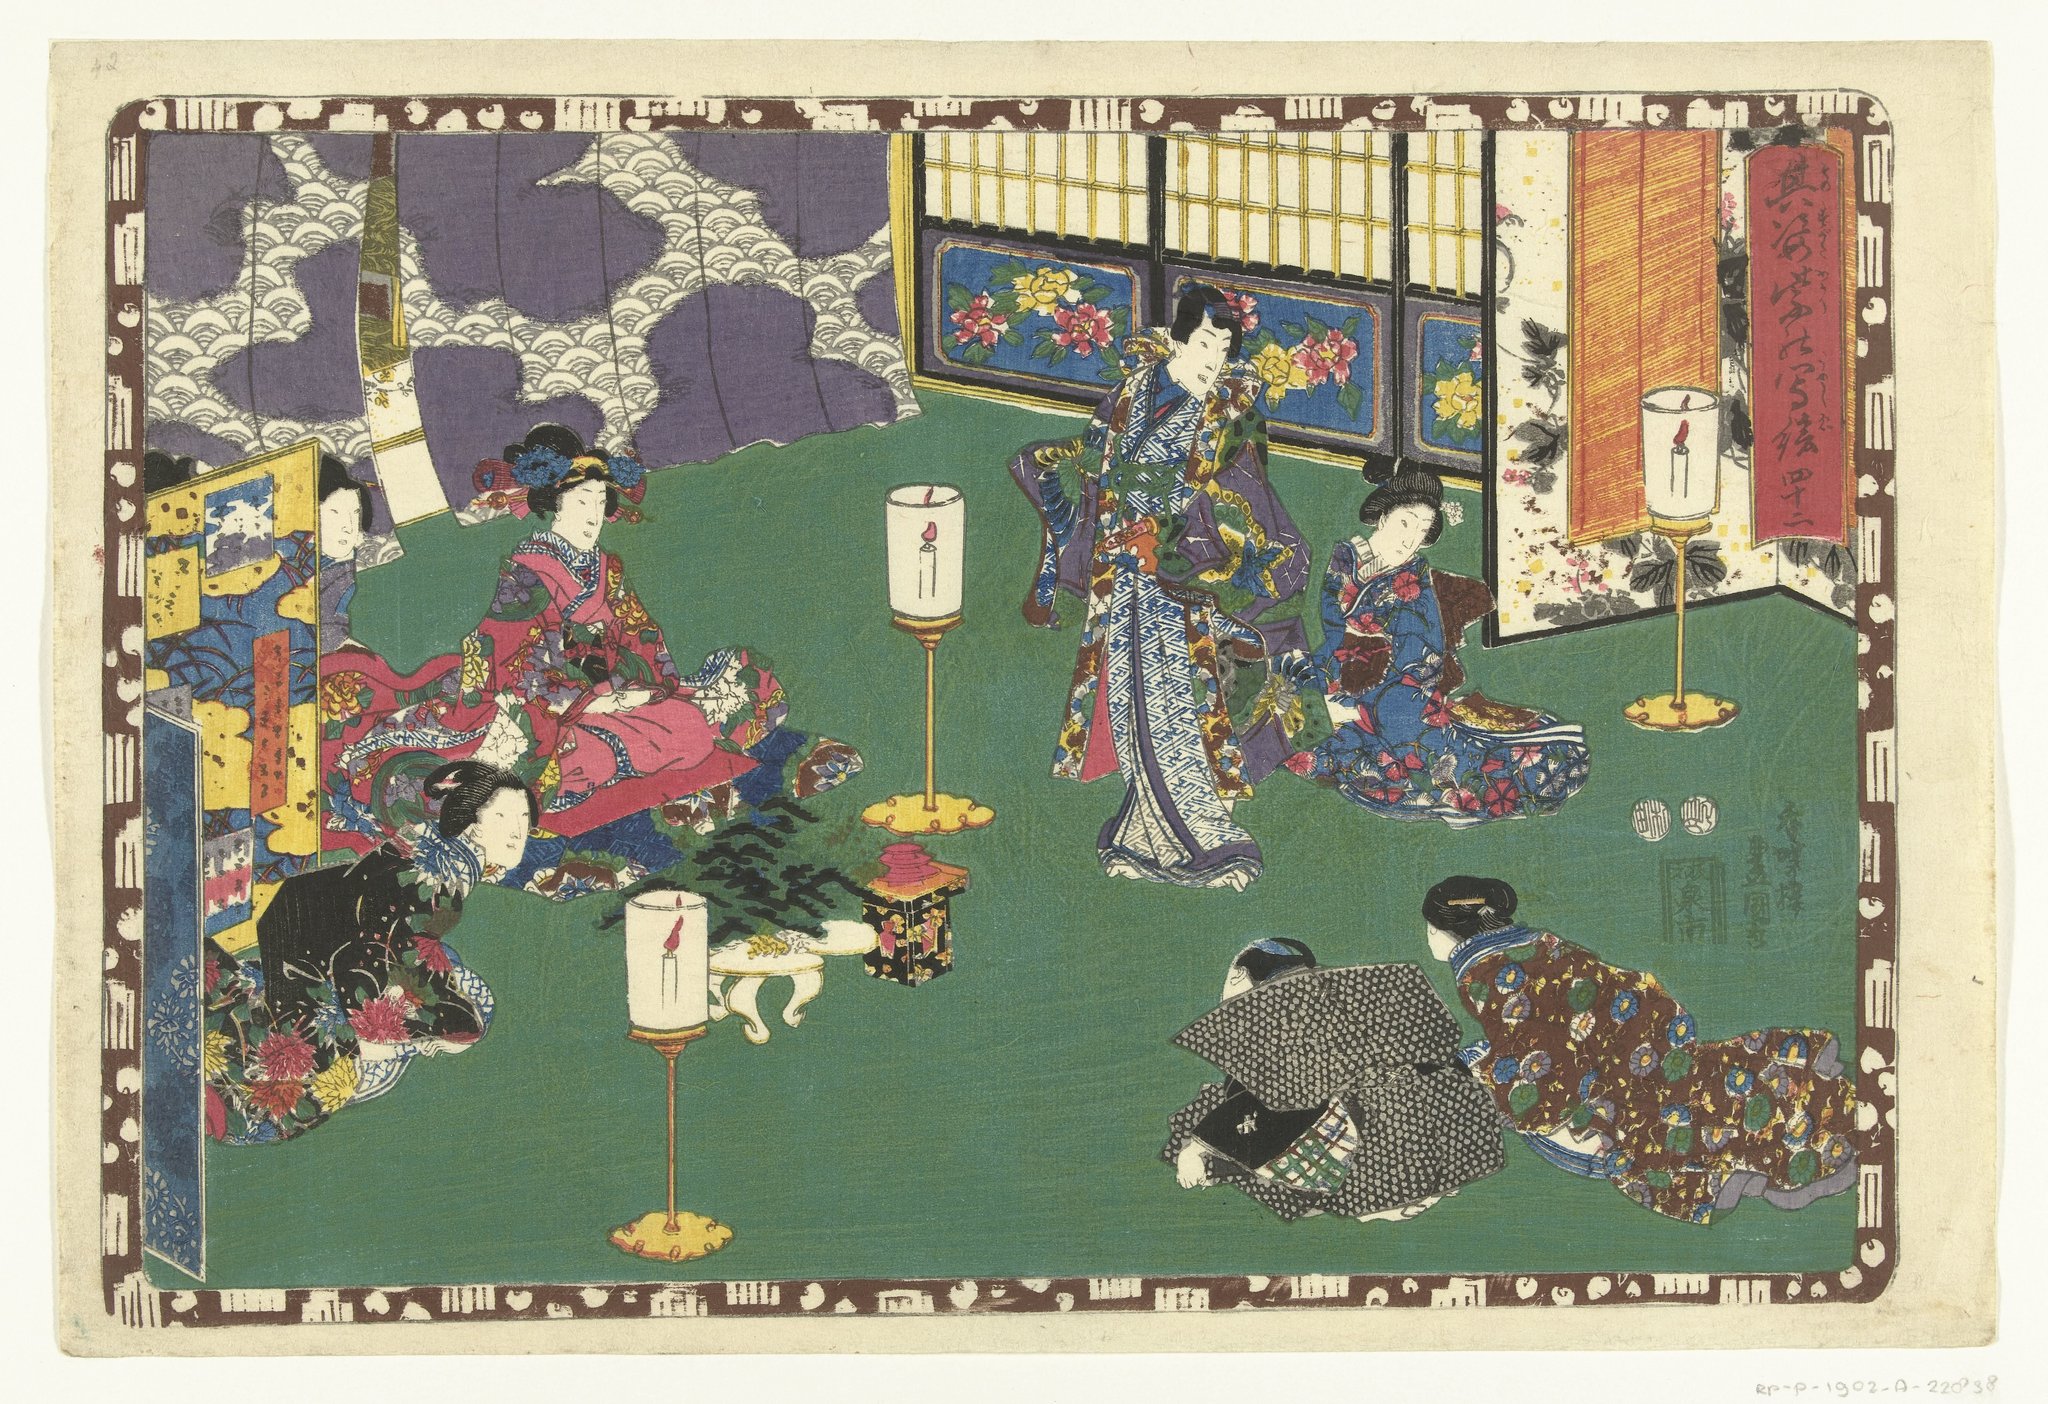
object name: print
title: Getrouwe afbeeldingen van de Schitterende Prins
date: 1851-1853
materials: paper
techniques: woodcut, nishiki e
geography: tokyo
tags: lantern, royal household; courtiers, retinue, train, kneeling figure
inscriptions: collector's mark: Lugt 2228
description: Elegant geklede man en vrouw, omringd door hofdames, kijkend naar knielende man en vrouw, op de rug gezien; in een grote kamer met drie staande lantaarns waarin kaarsen. Voorstelling omsloten door bruine rand waarin Genji emblemen.